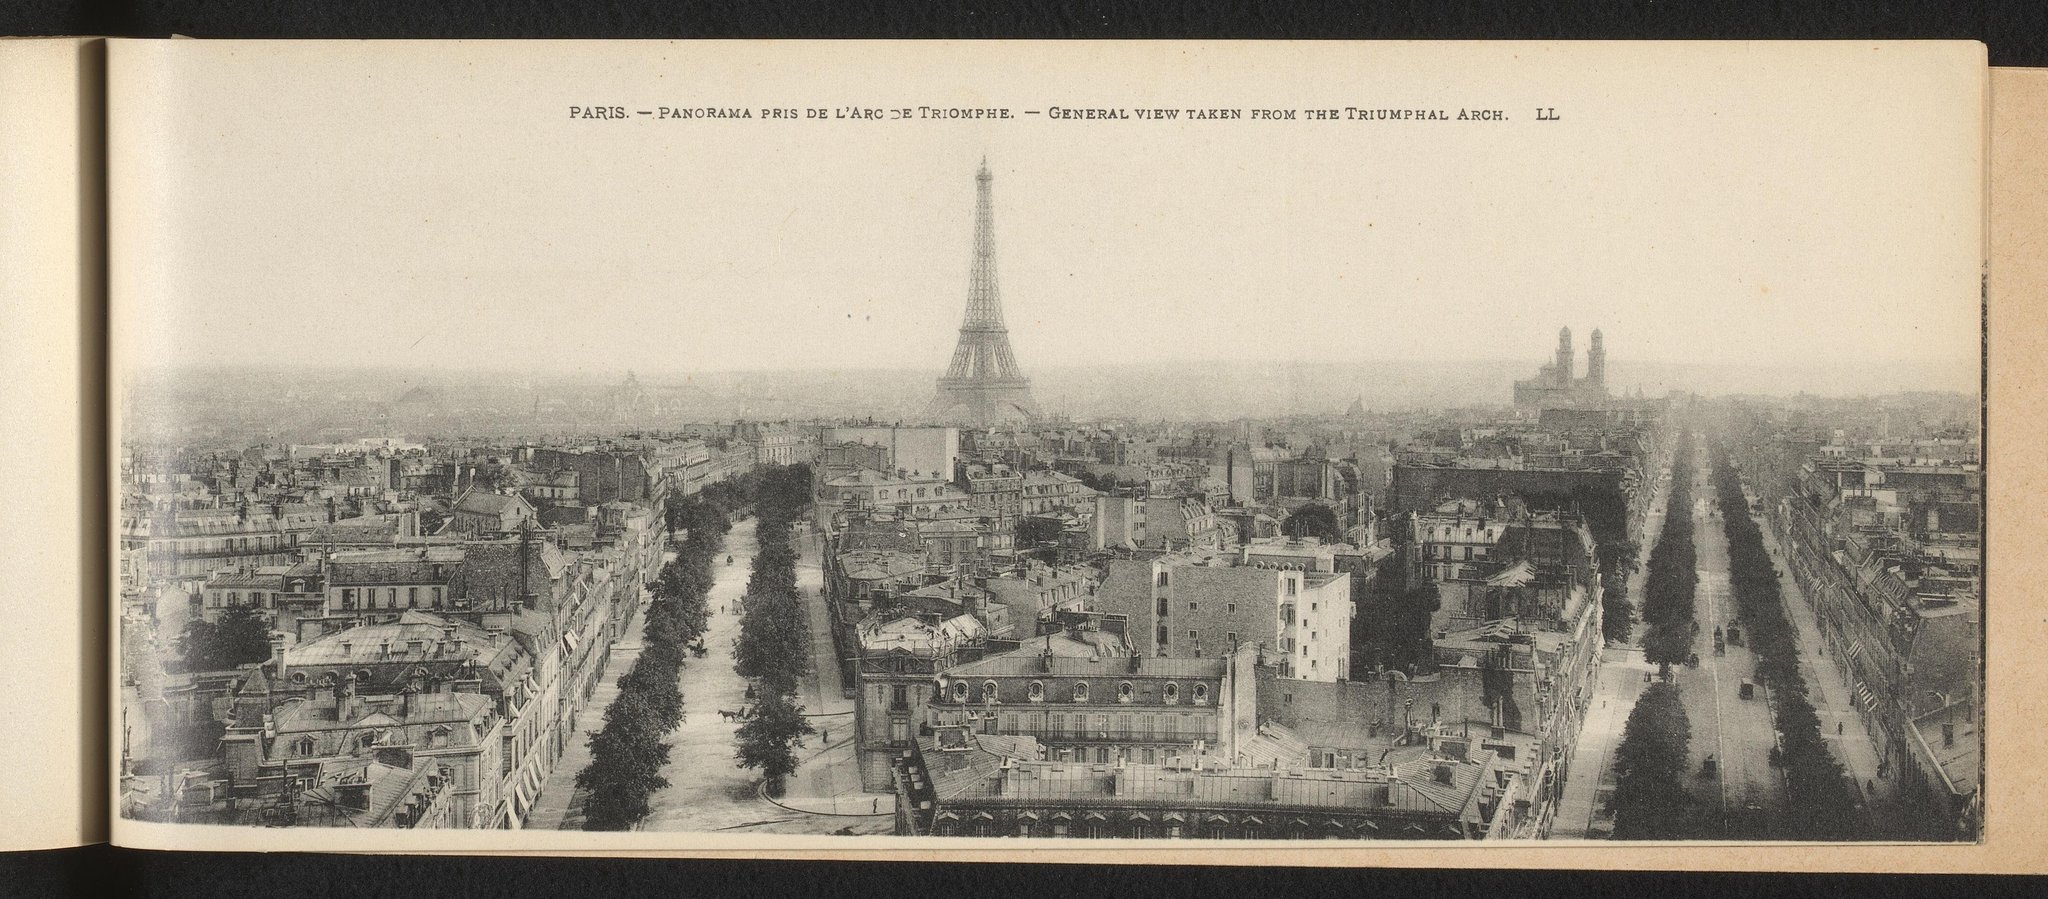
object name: photomechanical print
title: Paris. Panorama pris de l'Arc de Triomphe / General View Taken From the Triumphal Arch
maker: Anonymous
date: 1920-1932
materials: cardboard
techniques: photograph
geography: paris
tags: prospect of city, town panorama, silhouette of city (+ city(-scape) with figures, staffage), tower, clock tower ~ monumental adornment (+ city(-scape) with figures, staffage), paris